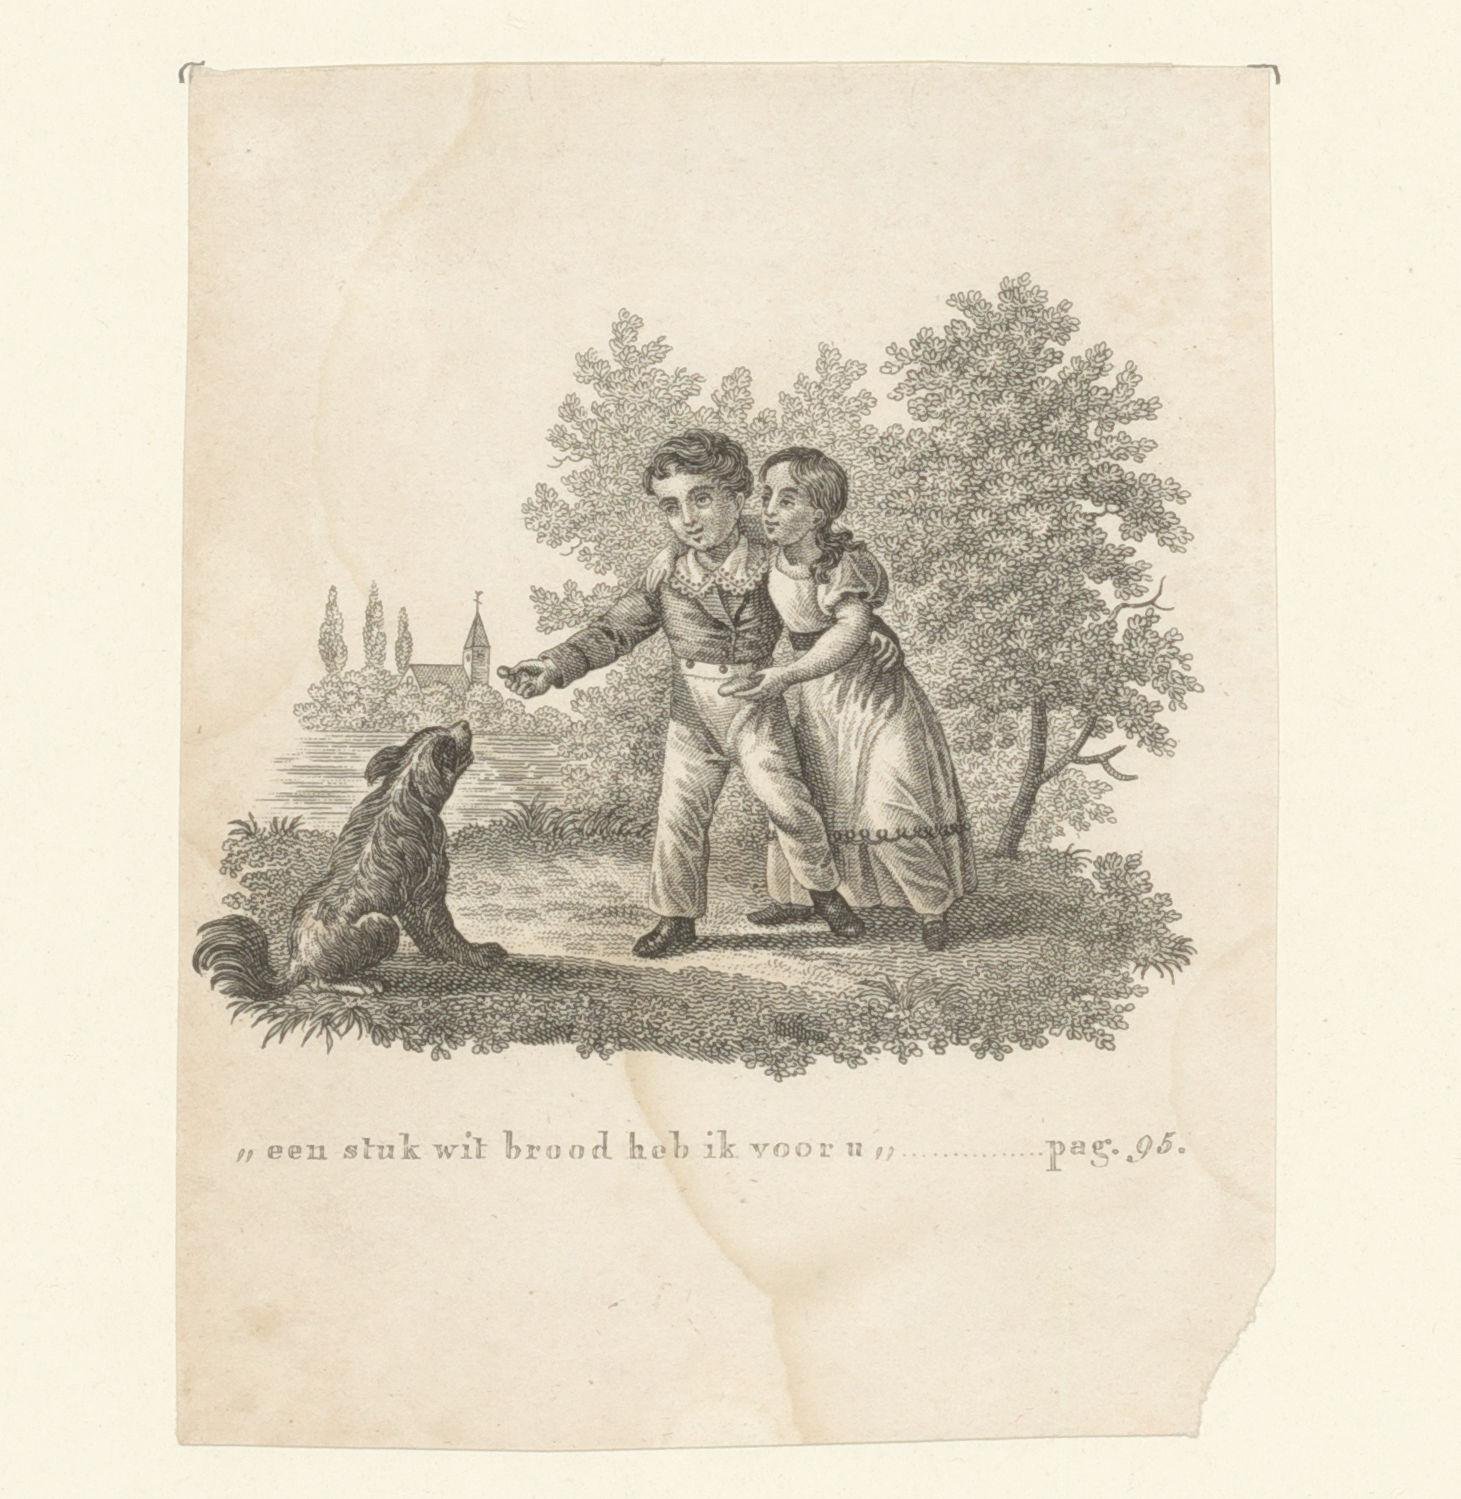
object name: print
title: Een stuk wit brood heb ik voor u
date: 1835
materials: paper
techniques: etching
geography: deventer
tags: giving food, child, dog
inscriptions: collector's mark: Lugt 1641, stamp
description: Rechtsonder genummerd: pag. 95. Onderwerpsrubrieken binnen de Atlas Zeden en Gewoonten: Zeden en Gewoonten in Engeren Zin, Des menschen beging, midden en einde, Kinderleven – Kinderspel en Kinderprenten.